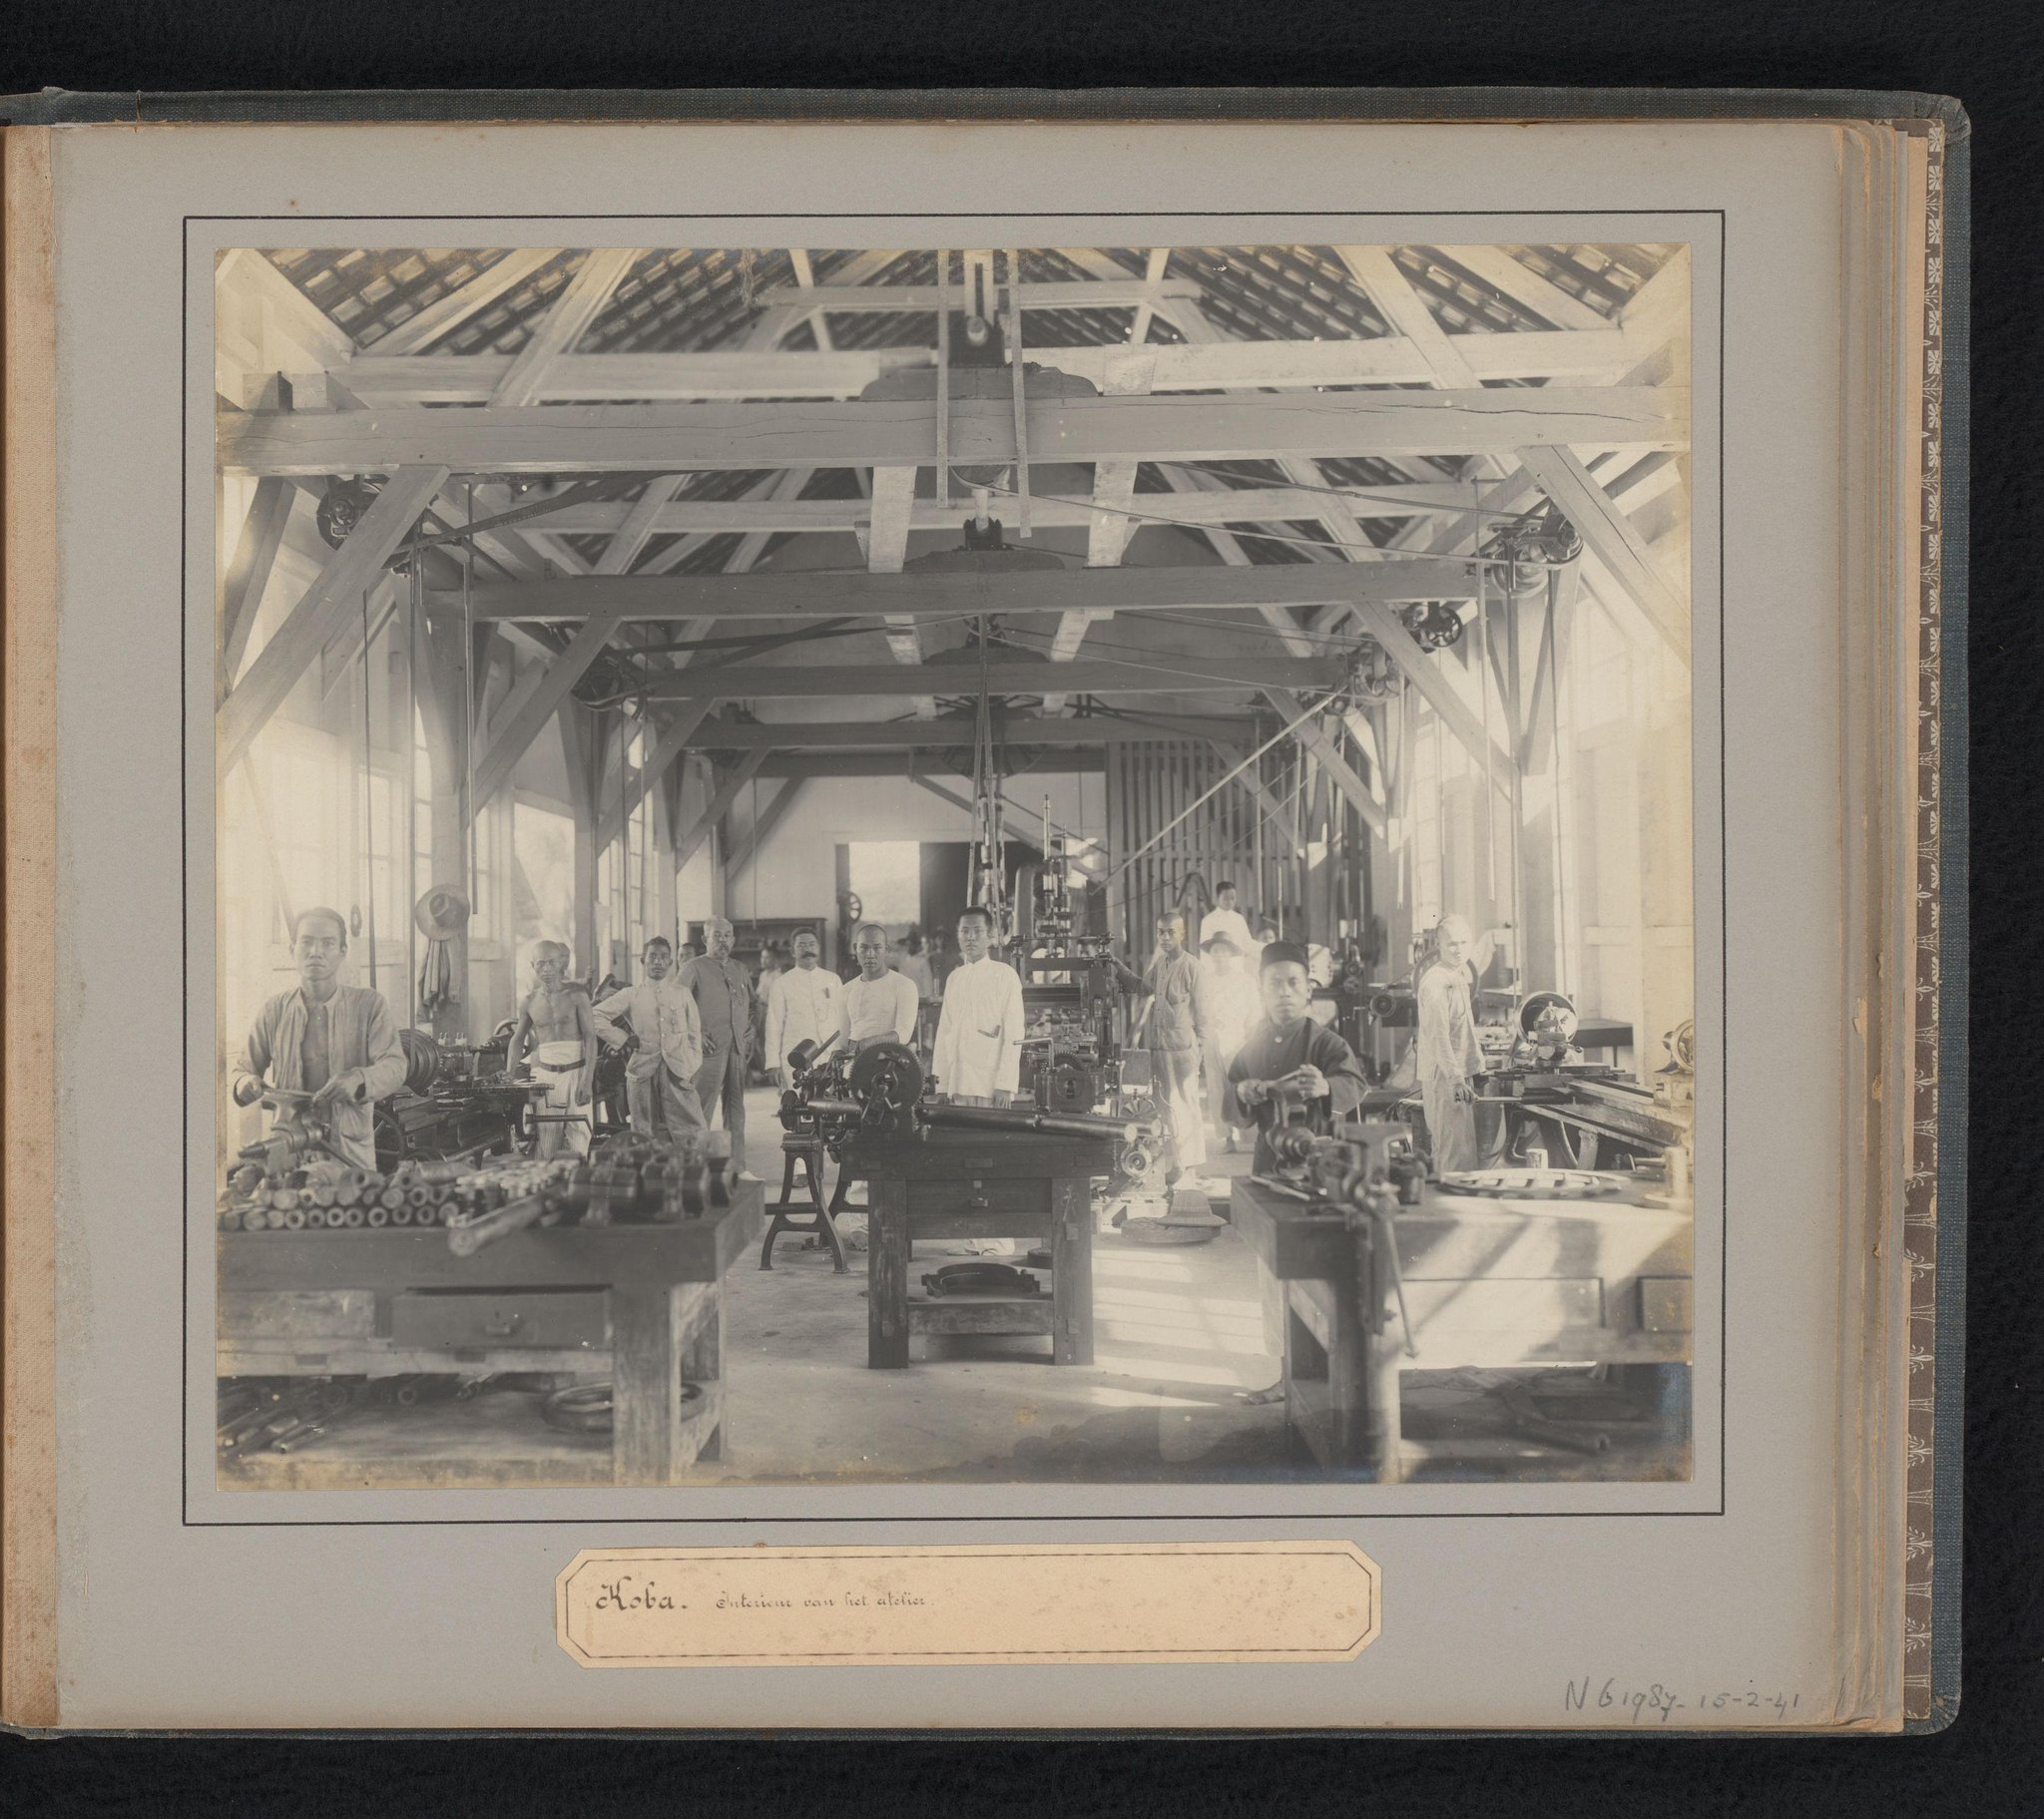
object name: photograph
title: Koba. Interieur van het atelier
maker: Anonymous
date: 1907-1919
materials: cardboard, photographic support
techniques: gelatin silver print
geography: bangka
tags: robert julius boers, colonial system, opencast mine; strip mining, minerals and metals: tin, workshop-interior (+ men (labourers))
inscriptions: label: ‘Koba. Interieur van het atelier’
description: Interieur van een werkplaats van de Banka-tinwinning te Koba. Personeel poseert bij de machines. Onderdeel van het fotoalbum over de Banka-tinwinning, ca. 1907-1919.